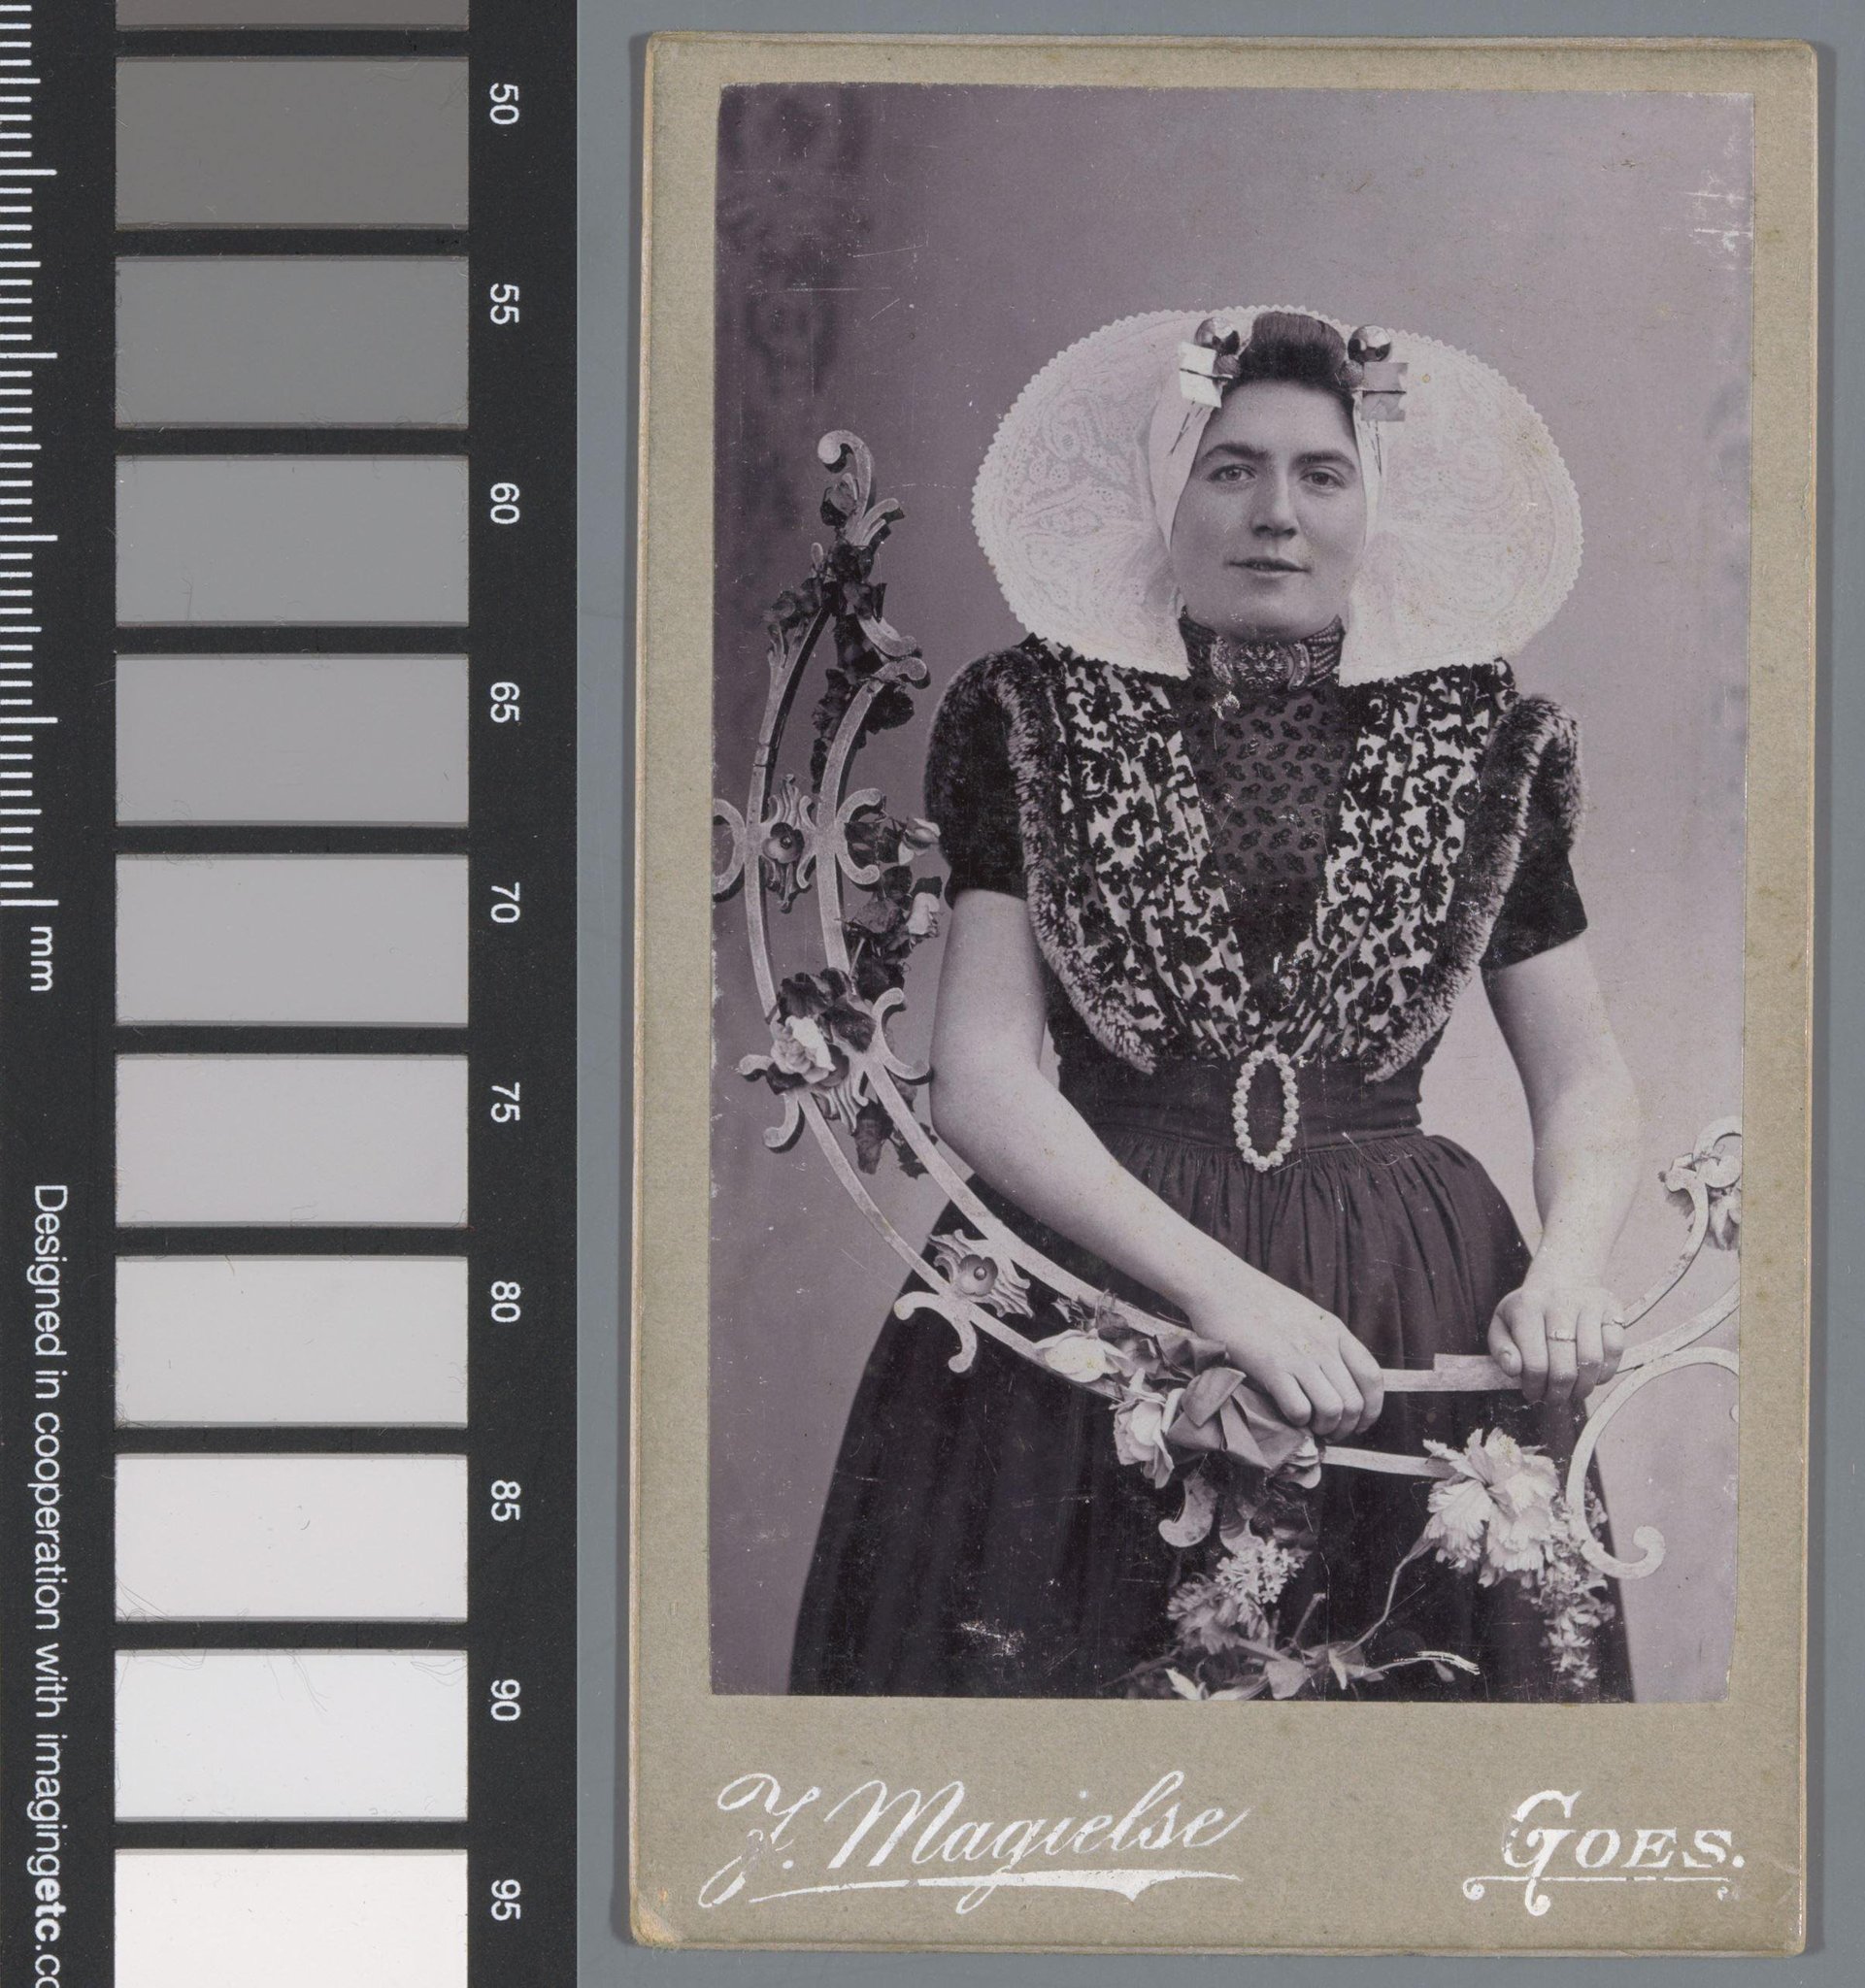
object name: carte de visite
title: Portret van een onbekende vrouw in klederdracht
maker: jacobus magielse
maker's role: fotograaf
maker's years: 1870-1941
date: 1894-1924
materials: paper, cardboard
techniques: collodion silver print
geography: goes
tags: adult woman, anonymous historical person portrayed, folk costume, regional costume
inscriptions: inscription: ‘J. Magielse/ Goes.’